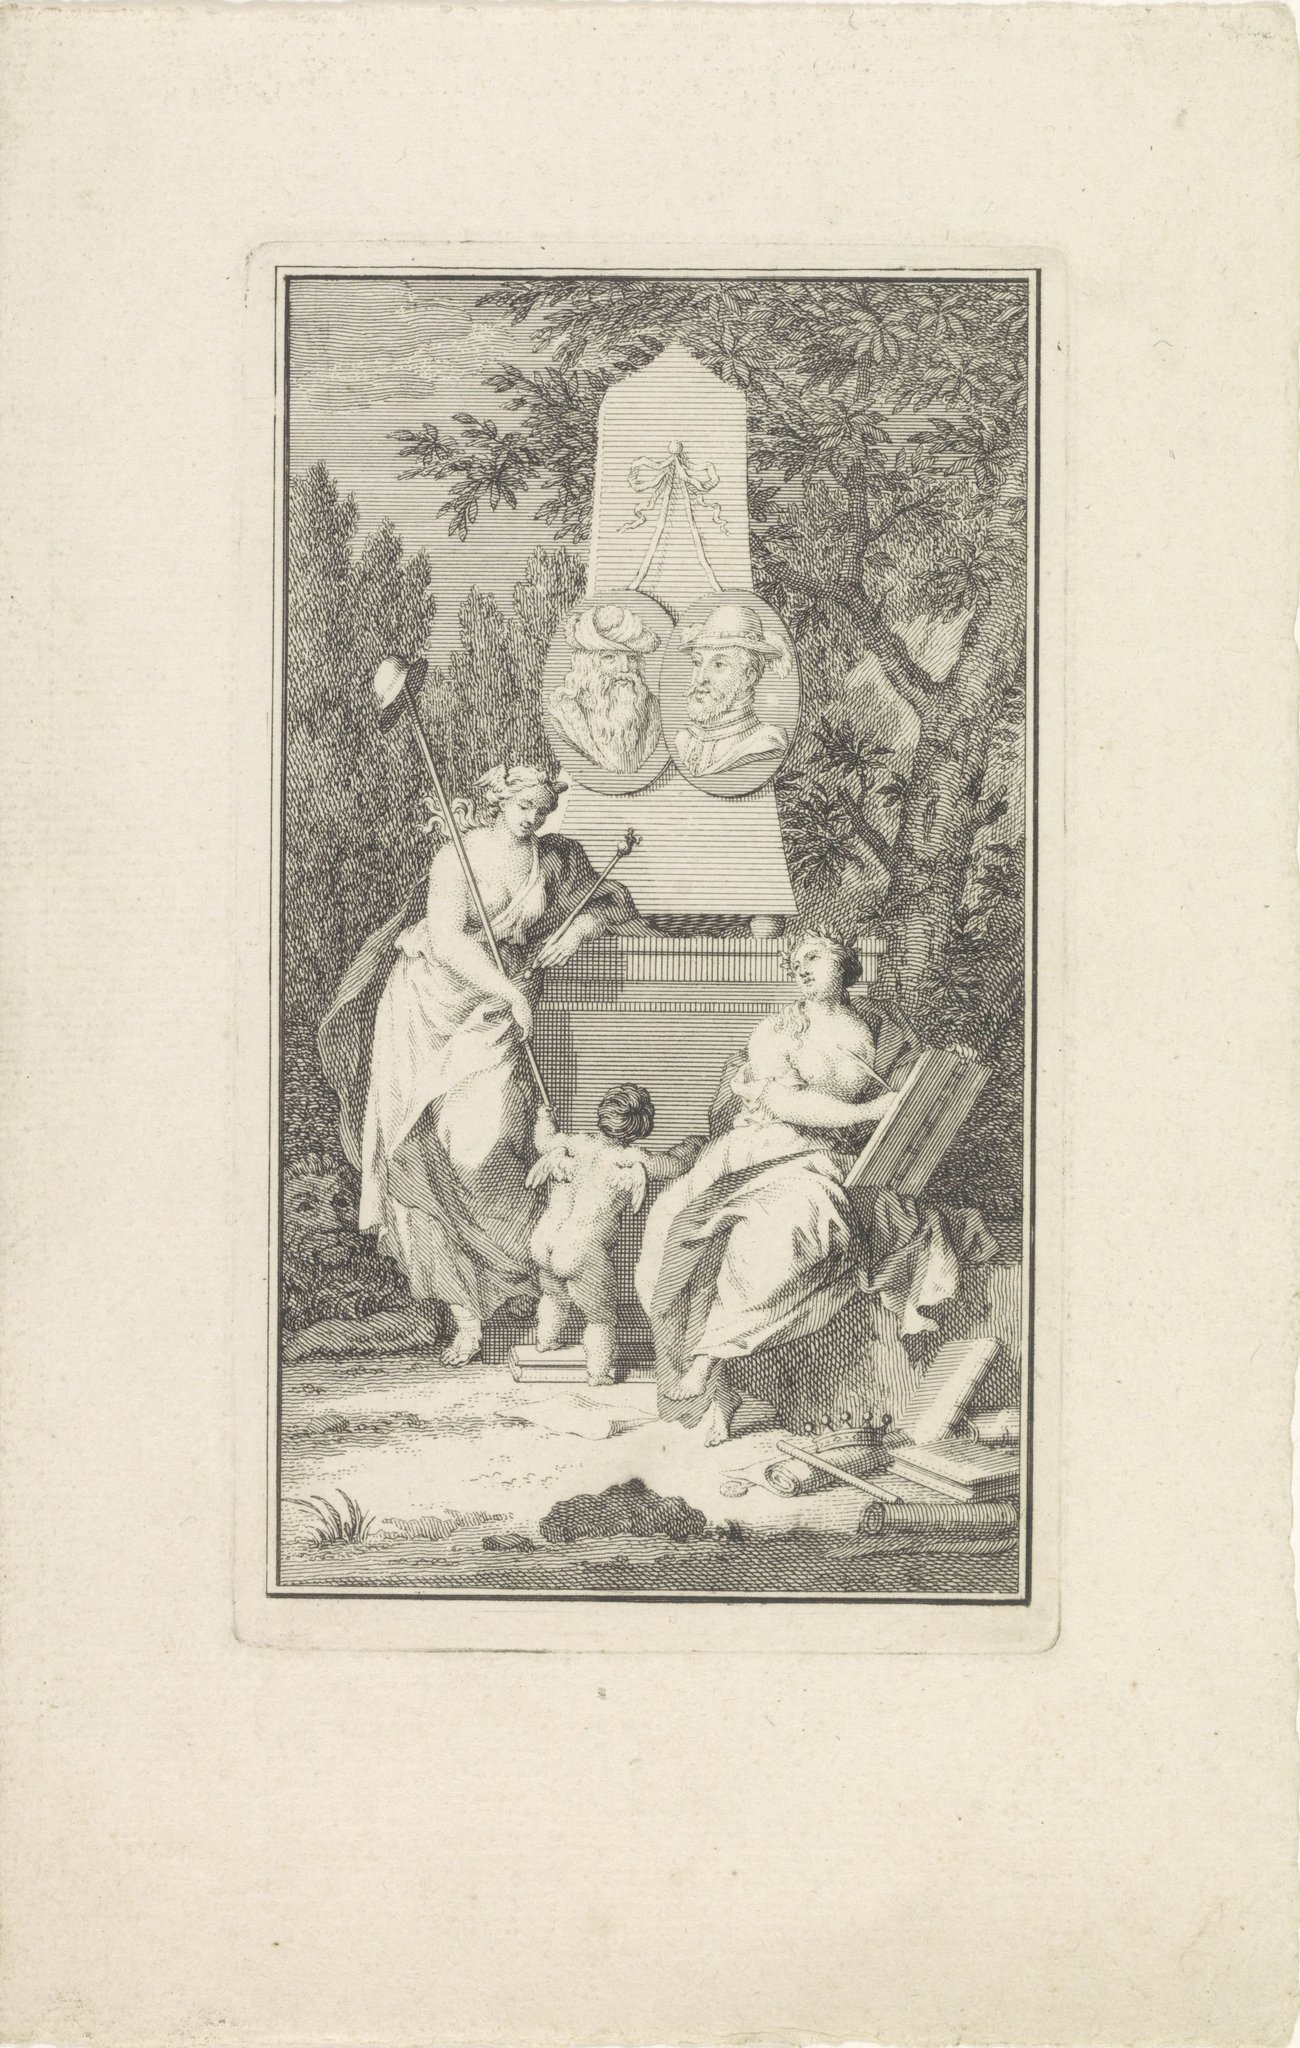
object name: print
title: Vrijheid en Clio bij een monument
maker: Anonymous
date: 1700-1800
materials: paper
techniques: etching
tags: monument, statue, 'historia'; 'historia' (ripa), freedom, liberty; 'libertà' (ripa), clio (one of the muses); 'clio' (ripa)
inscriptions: collector's mark: Lugt 2228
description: Bij een monument waaraan twee portretten hangen, het een van een man met tulband en het andere van een man met hoed en baard, staat de personificatie van Vrijheid met de vrijheidslans met vrijheidshoed. Een putto staat bij haar. Rechts zit de Muze van de geschiedenis, Clio. Ze schrijft met een schrijfveer in haar boek. Op het hoofd draagt zij een lauwerkrans. Op de grond liggen een kroon, scepter, boeken en documenten.